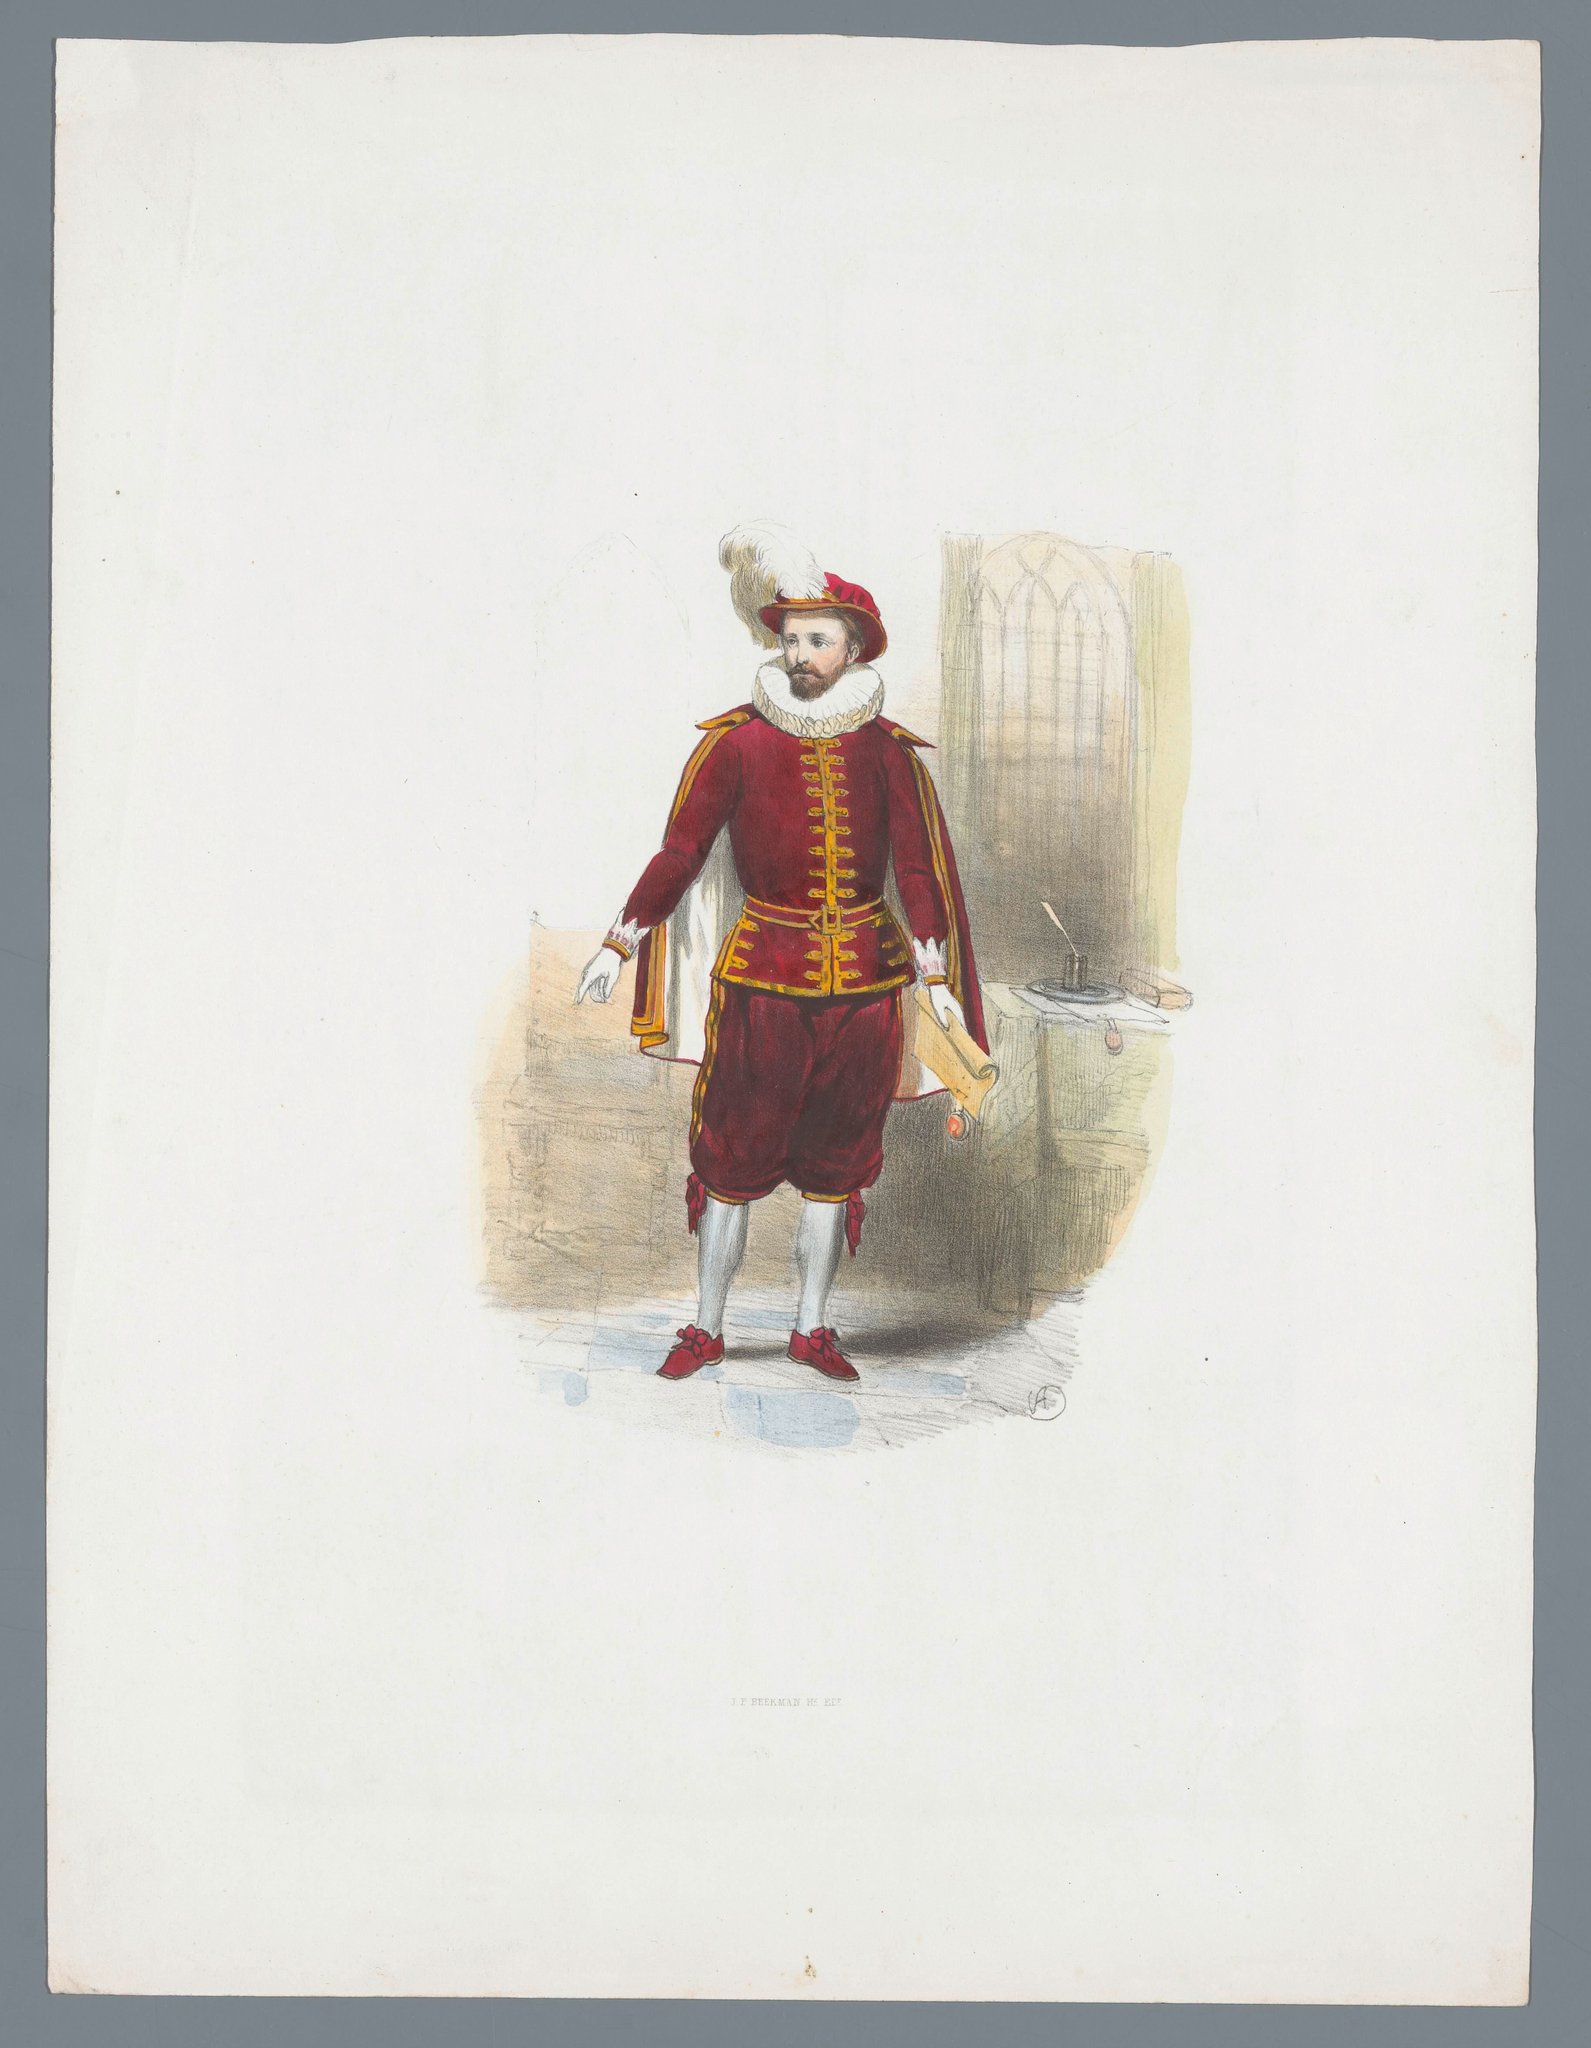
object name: costume print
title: Man in historisch kostuum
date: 1841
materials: paper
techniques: hand coloring, lithograph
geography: the hague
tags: anna paulowna romanowa, the hague, william ii of the netherlands, historical costume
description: Man in historisch kostuum, staande bij een schrijftafel met document in de hand. Kostuum gedragen op het gekostumeerde bal gehouden te Den Haag op 17 en 19 februari 1841 bij het 25-jarig huwelijk van koning Willem II en Anna Paulowna.